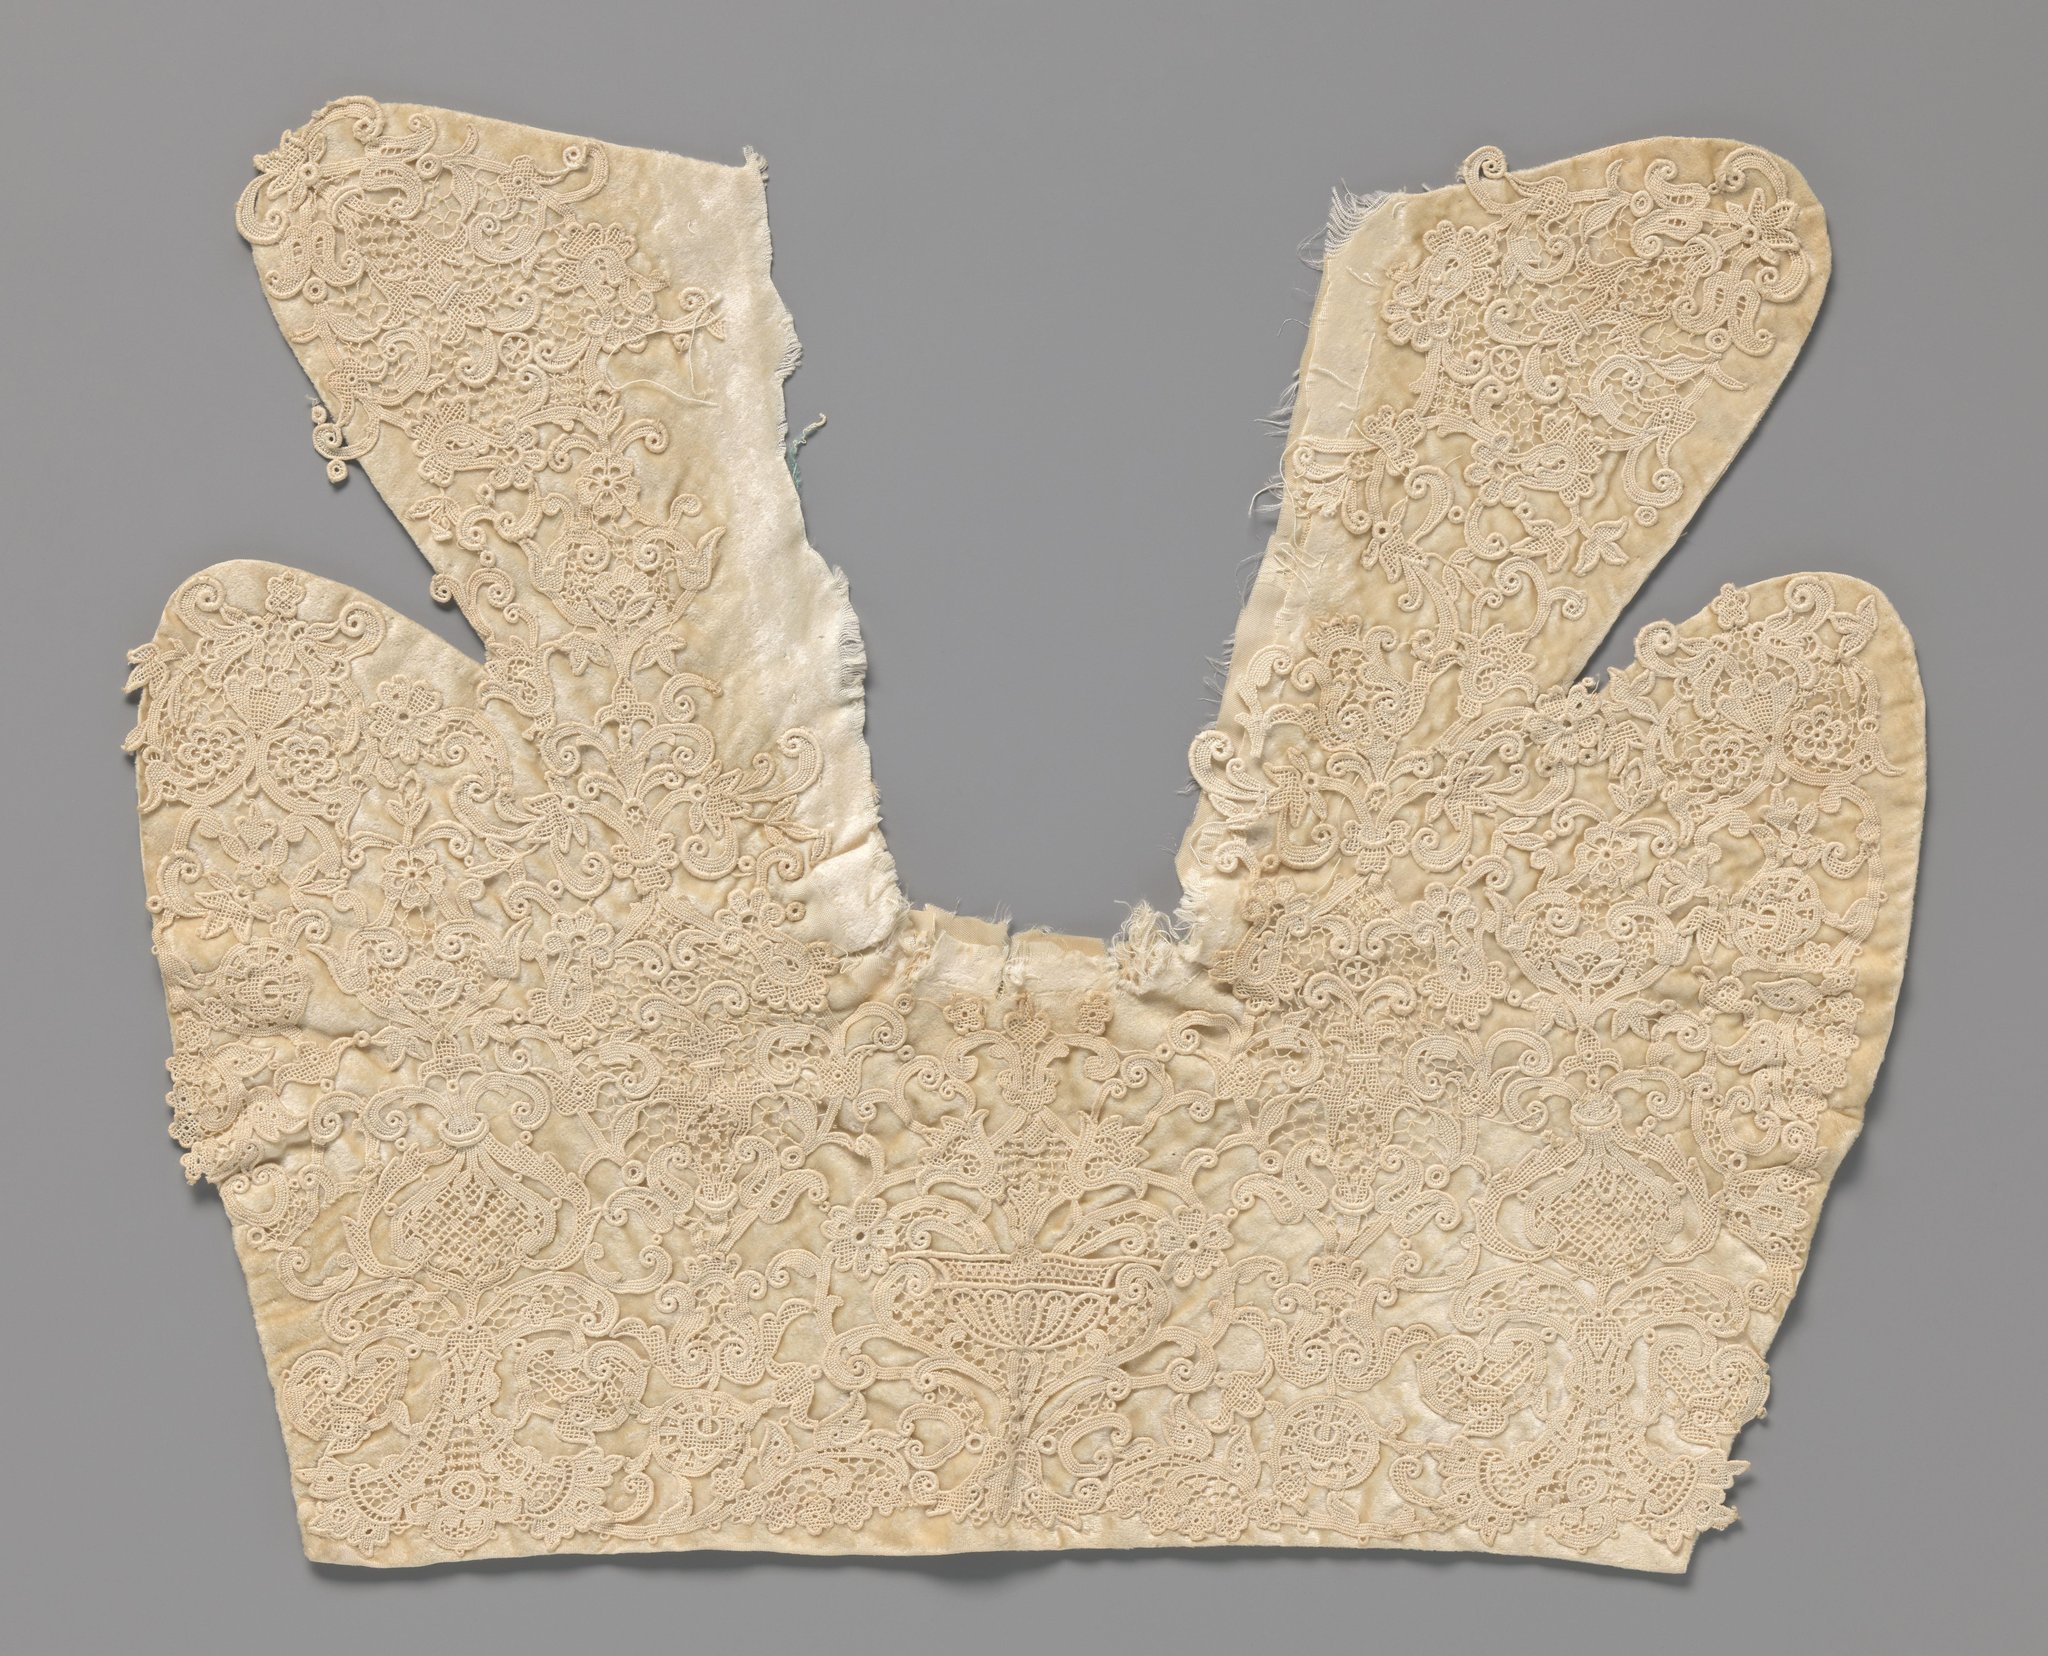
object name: collar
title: Kraag van machinale kant geappliceerd op crèmekleurig fluweel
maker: Anonymous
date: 1900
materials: cotton, textile, velvet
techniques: lace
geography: switzerland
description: Kraag van naturelkleurige machinale kant: etskant. Het kant imiteert naaldkant - platte Venetiaanse kant - en is geappliceerd op crèmekleurig fluweel en met een crèmekleurig voering van satijn. Trapeziumvormig met een inkeping aan beide zijkanten met afgeronde hoeken en een u-vormige hals- of neklijn. De onderzijde is recht, zonder afgeronde hoeken.